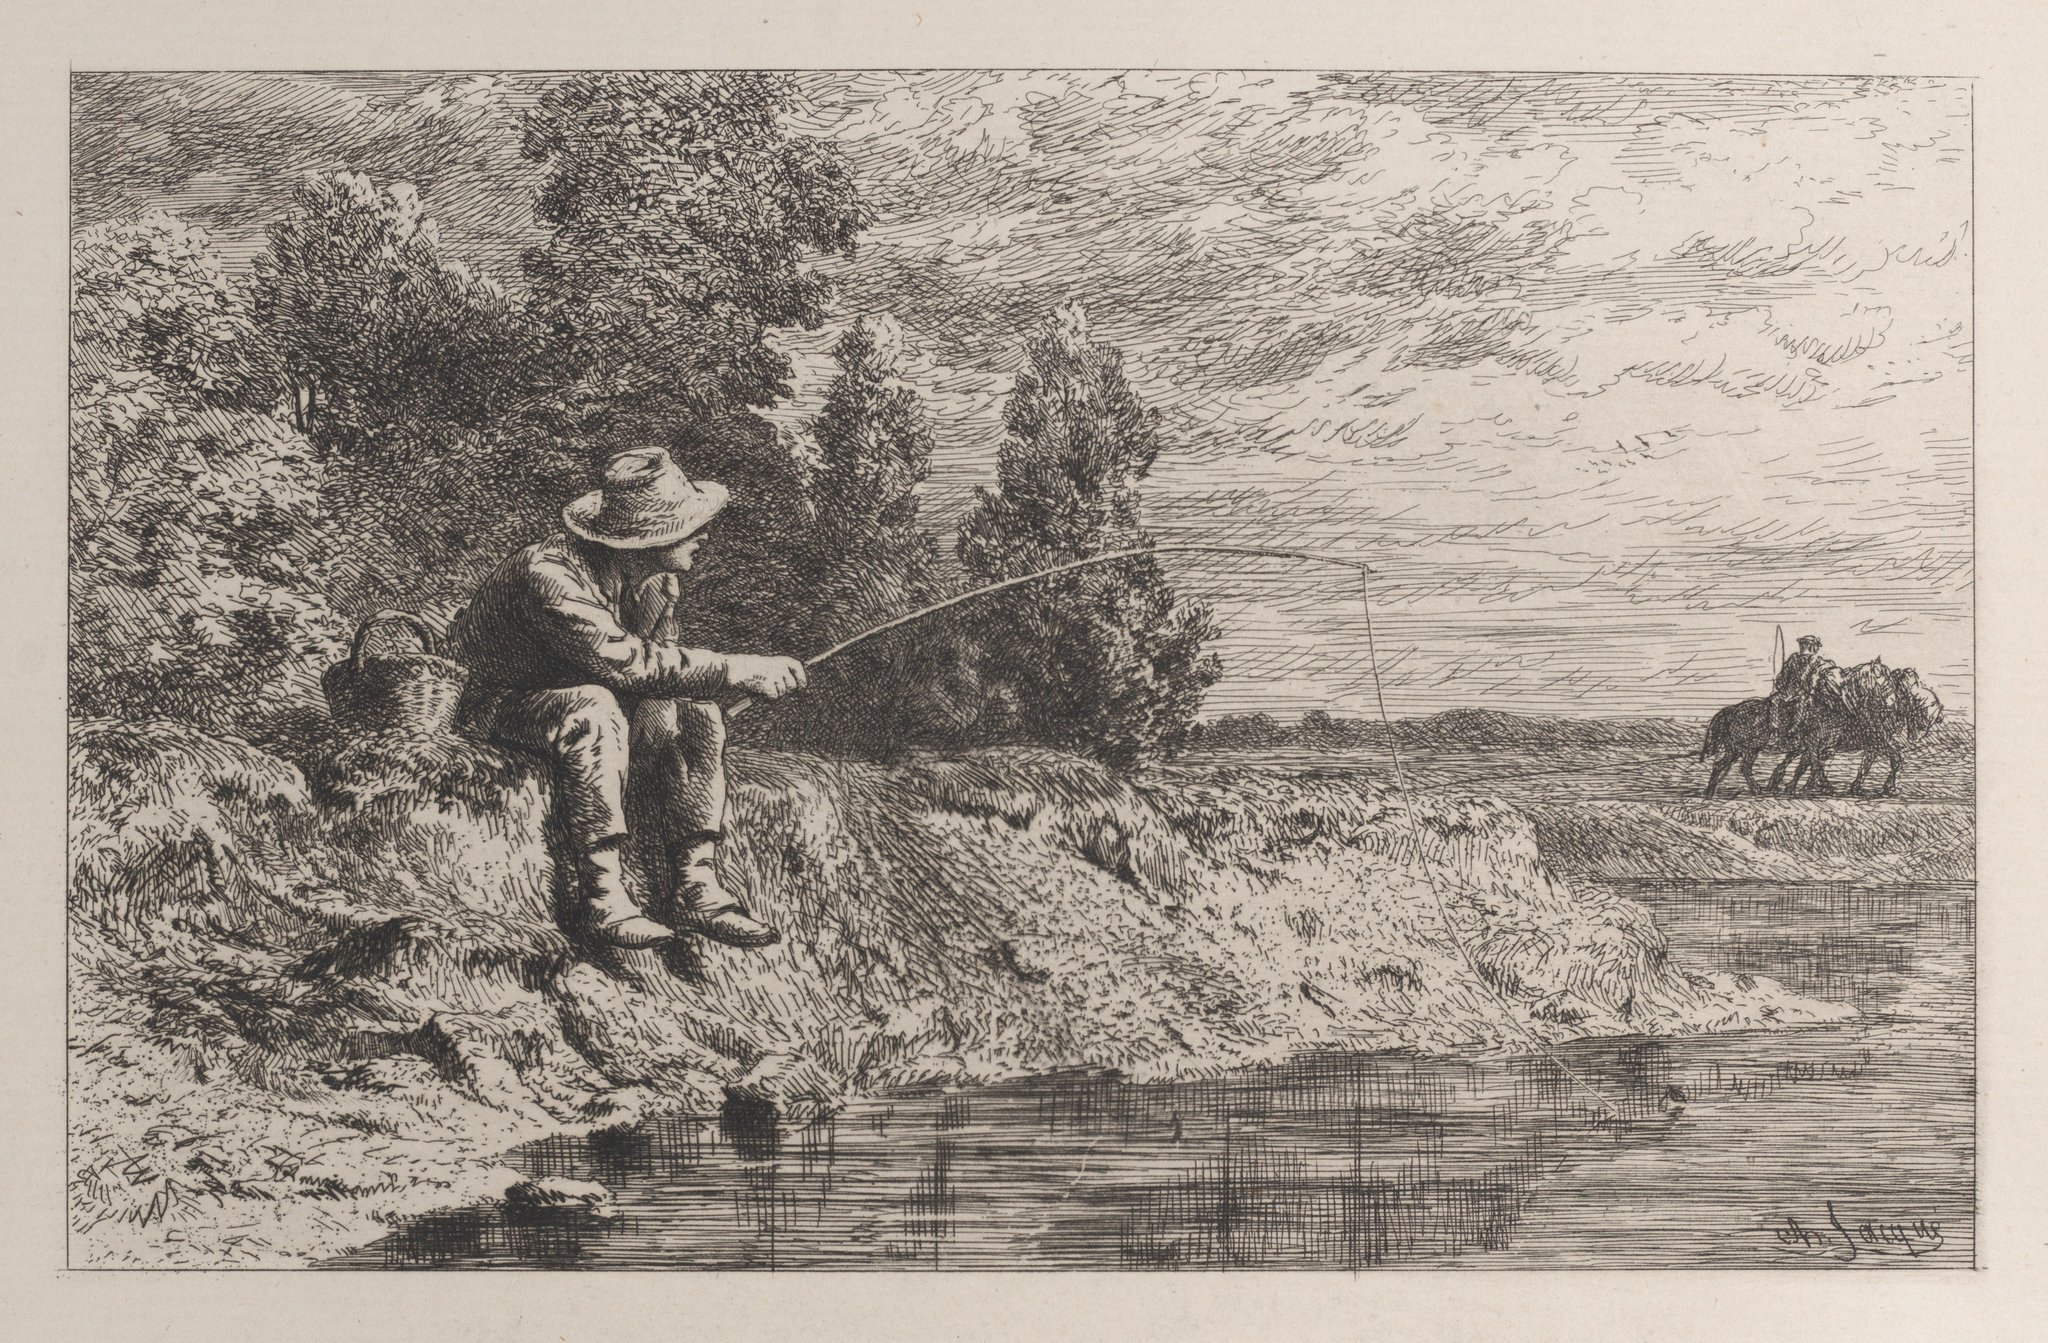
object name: print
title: Fishing for Roach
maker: charles émile jacque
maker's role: artist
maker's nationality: french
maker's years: 1813-1894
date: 1865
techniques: etching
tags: men,fishing